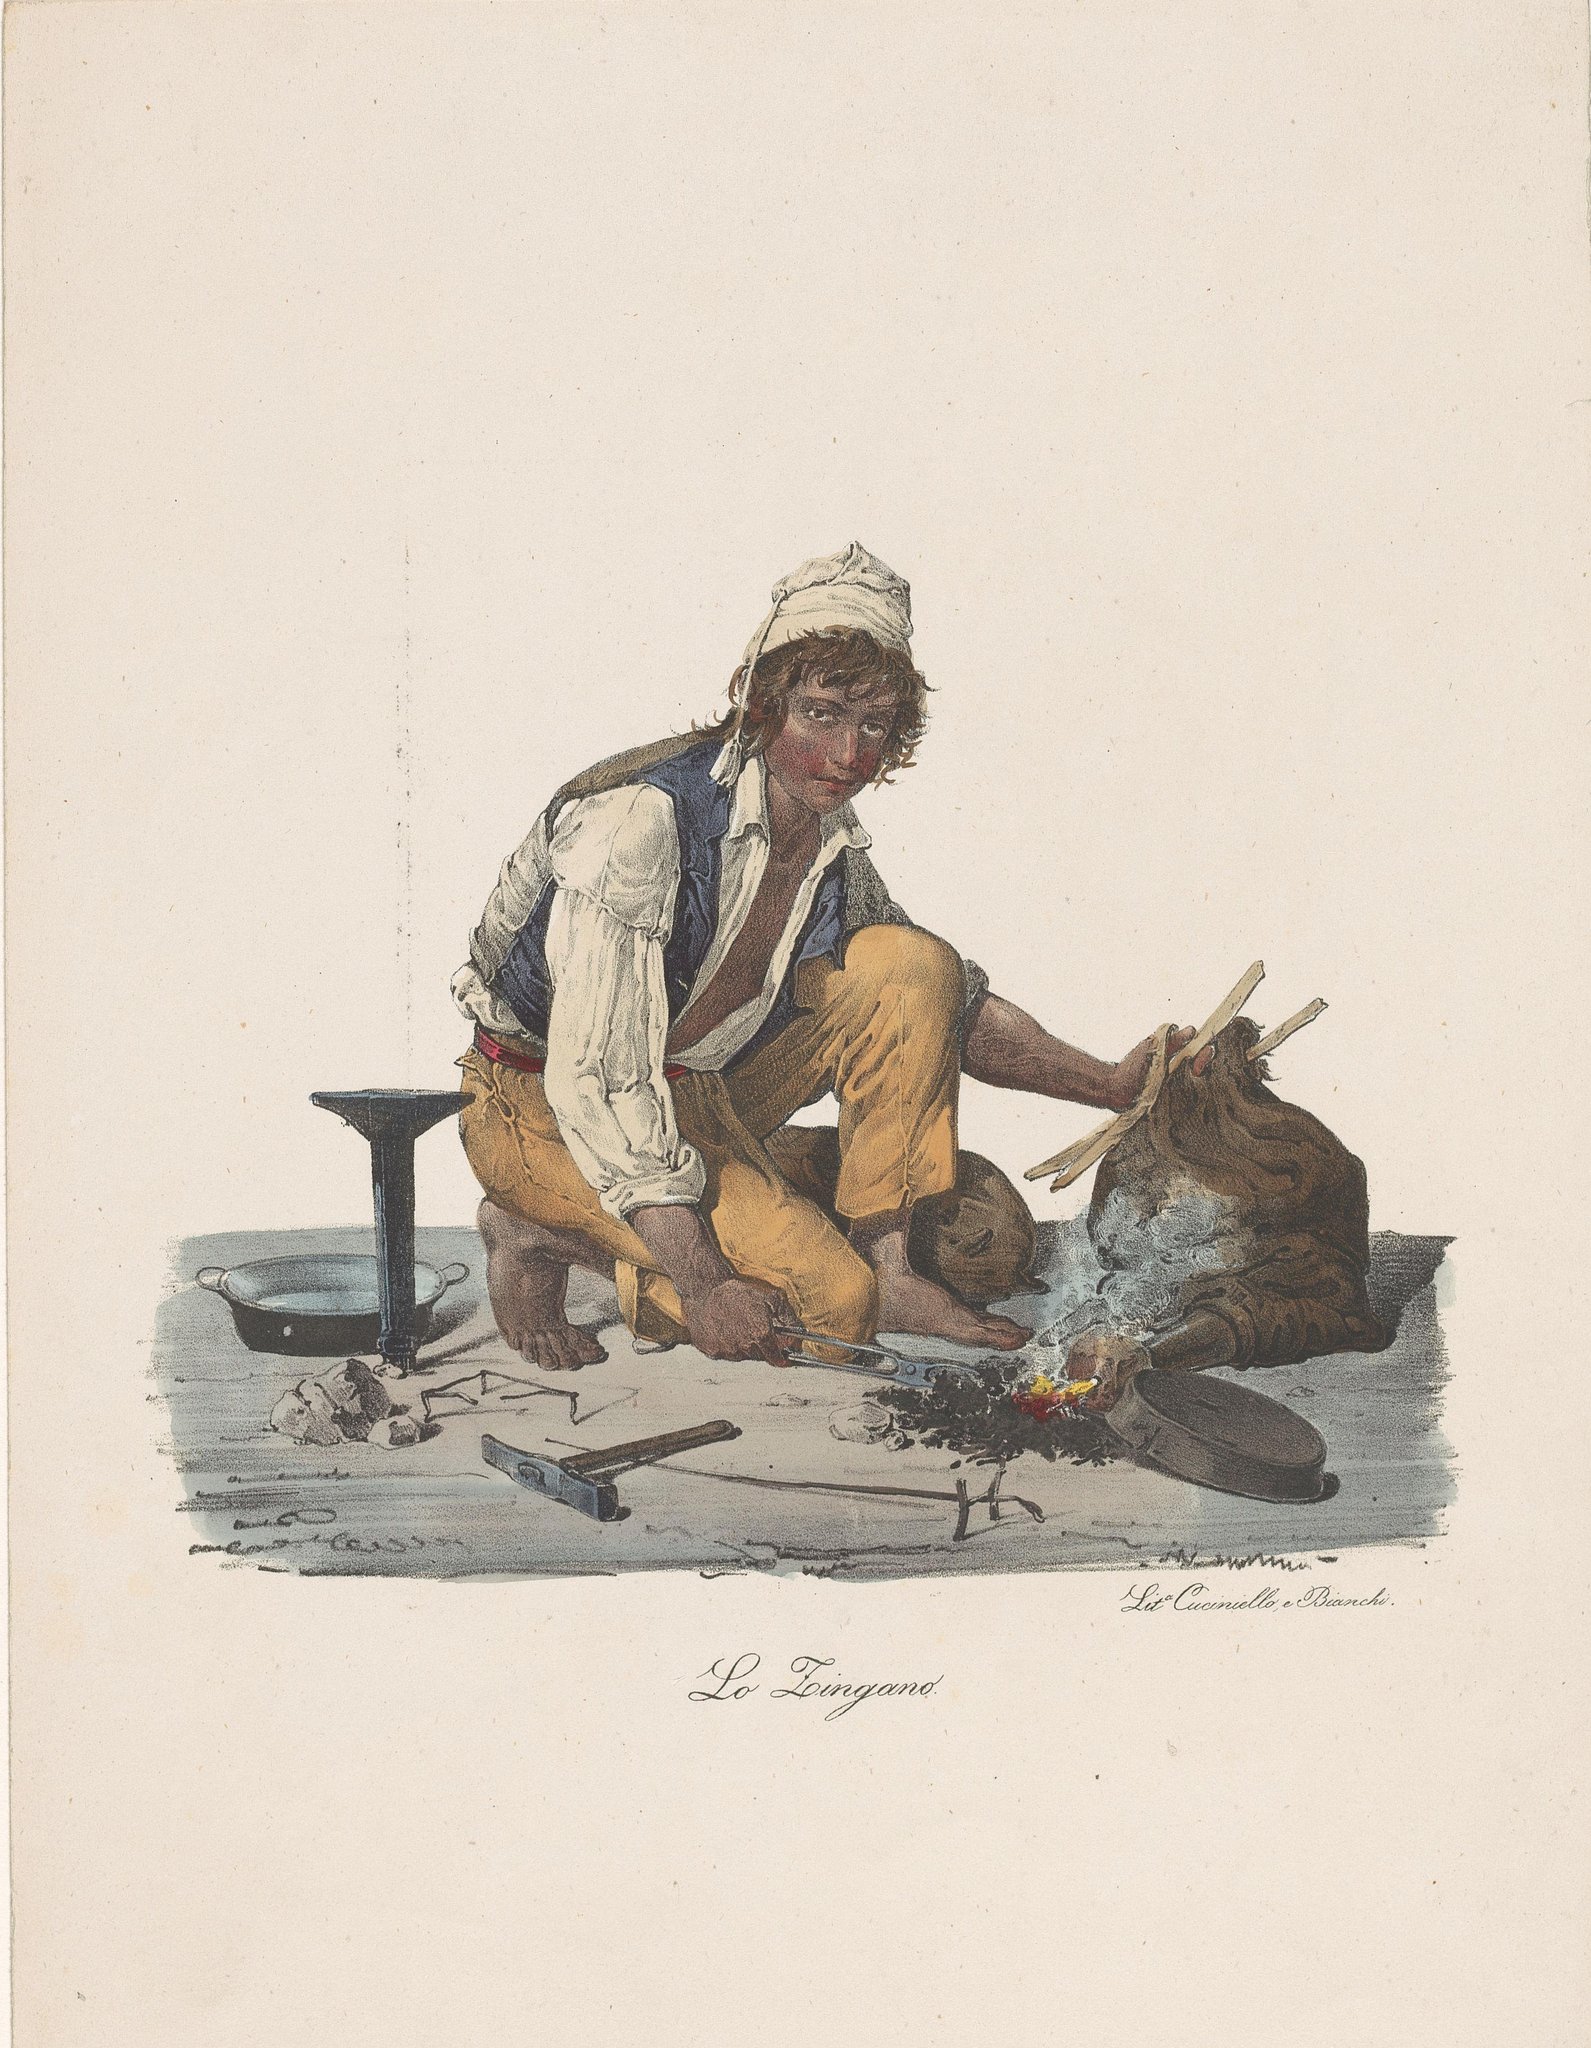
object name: print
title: Zigeunerjongen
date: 1800-1899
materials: paper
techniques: hand coloring, lithograph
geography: italy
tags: wandering communities: romani or roma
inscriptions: collector's mark: Lugt 2228